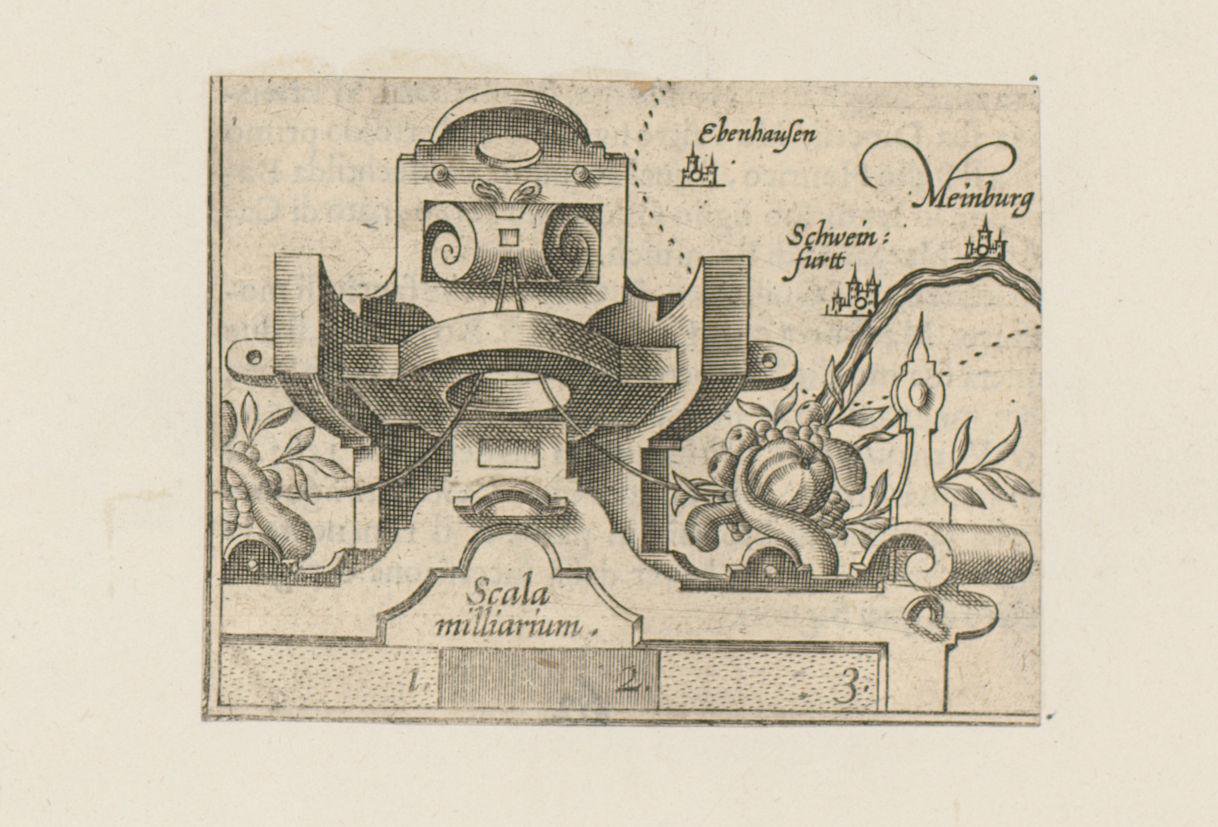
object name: print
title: Cartouche van een kaart van Henneberg en Hessen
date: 1595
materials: paper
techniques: engraving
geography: antwerp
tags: fruits and vegetables ~ ornament, scrollwork, strapwork ~ ornament, ornament ~ cartouche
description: De cartouche is gekopieerd naar een prent van een anonieme graveur naar het ontwerp van Hans Vredeman de Vries, onderdeel van een serie van rolwerkcartouches met grotesken uit circa 1555-1560.